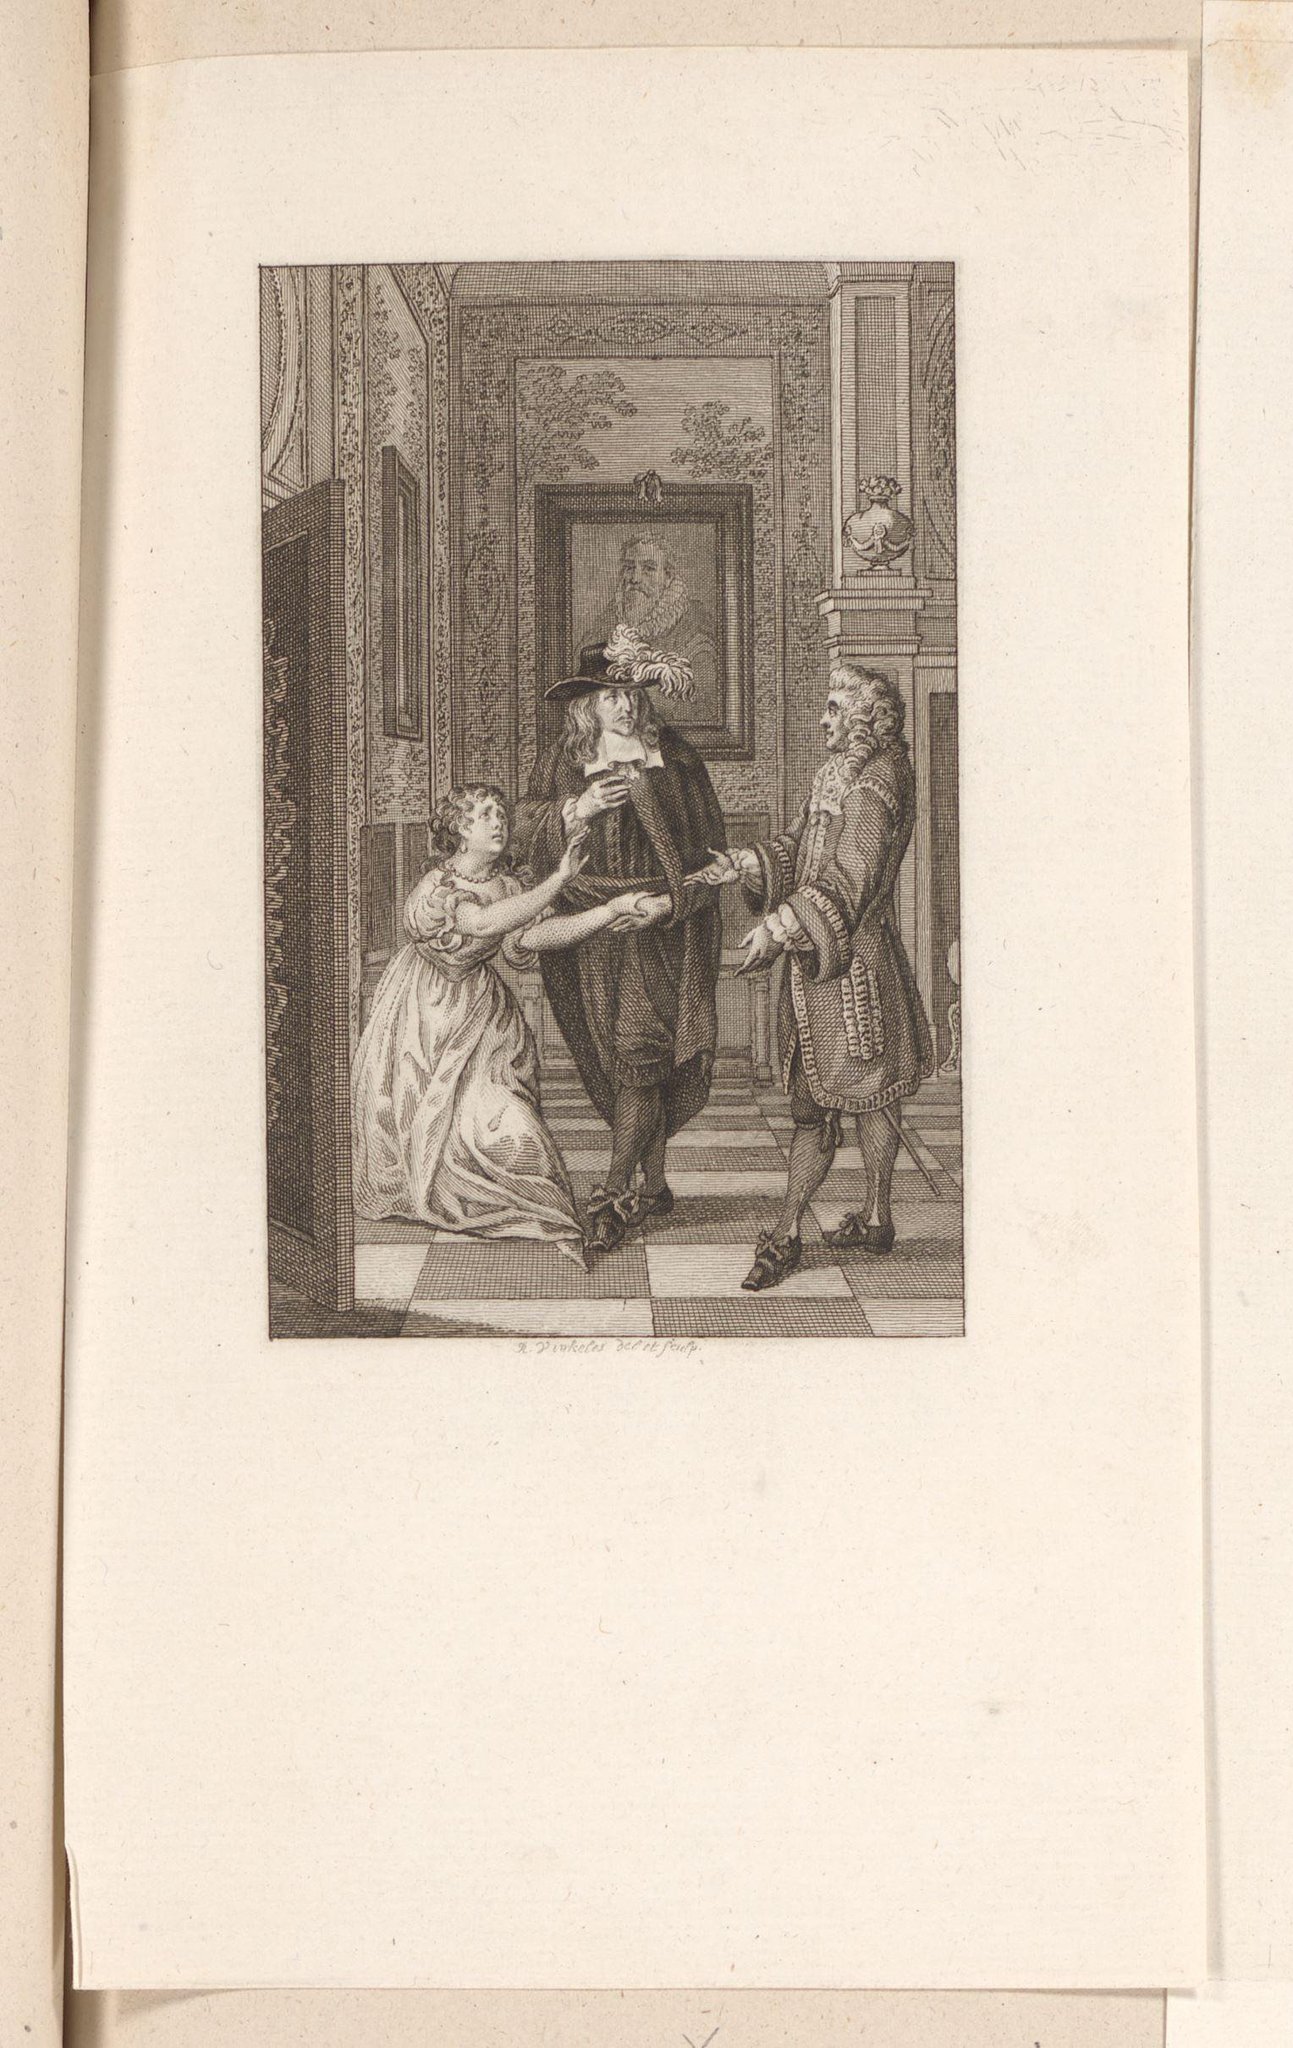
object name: album leaf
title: Johan de Witt door zijn dochter tegengehouden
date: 1805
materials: paper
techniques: engraving, etching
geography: haarlem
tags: politician, johan de witt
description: Johan de Witt net voordat hij door de deur uitgaat. Hij werd in de val gelokt met de mededeling dat zijn broer hem wilde spreken. Anna probeert haar vader tegen te houden. Links staat zijn zwager Van Zwijndrecht. De prent maakt deel uit van een album.